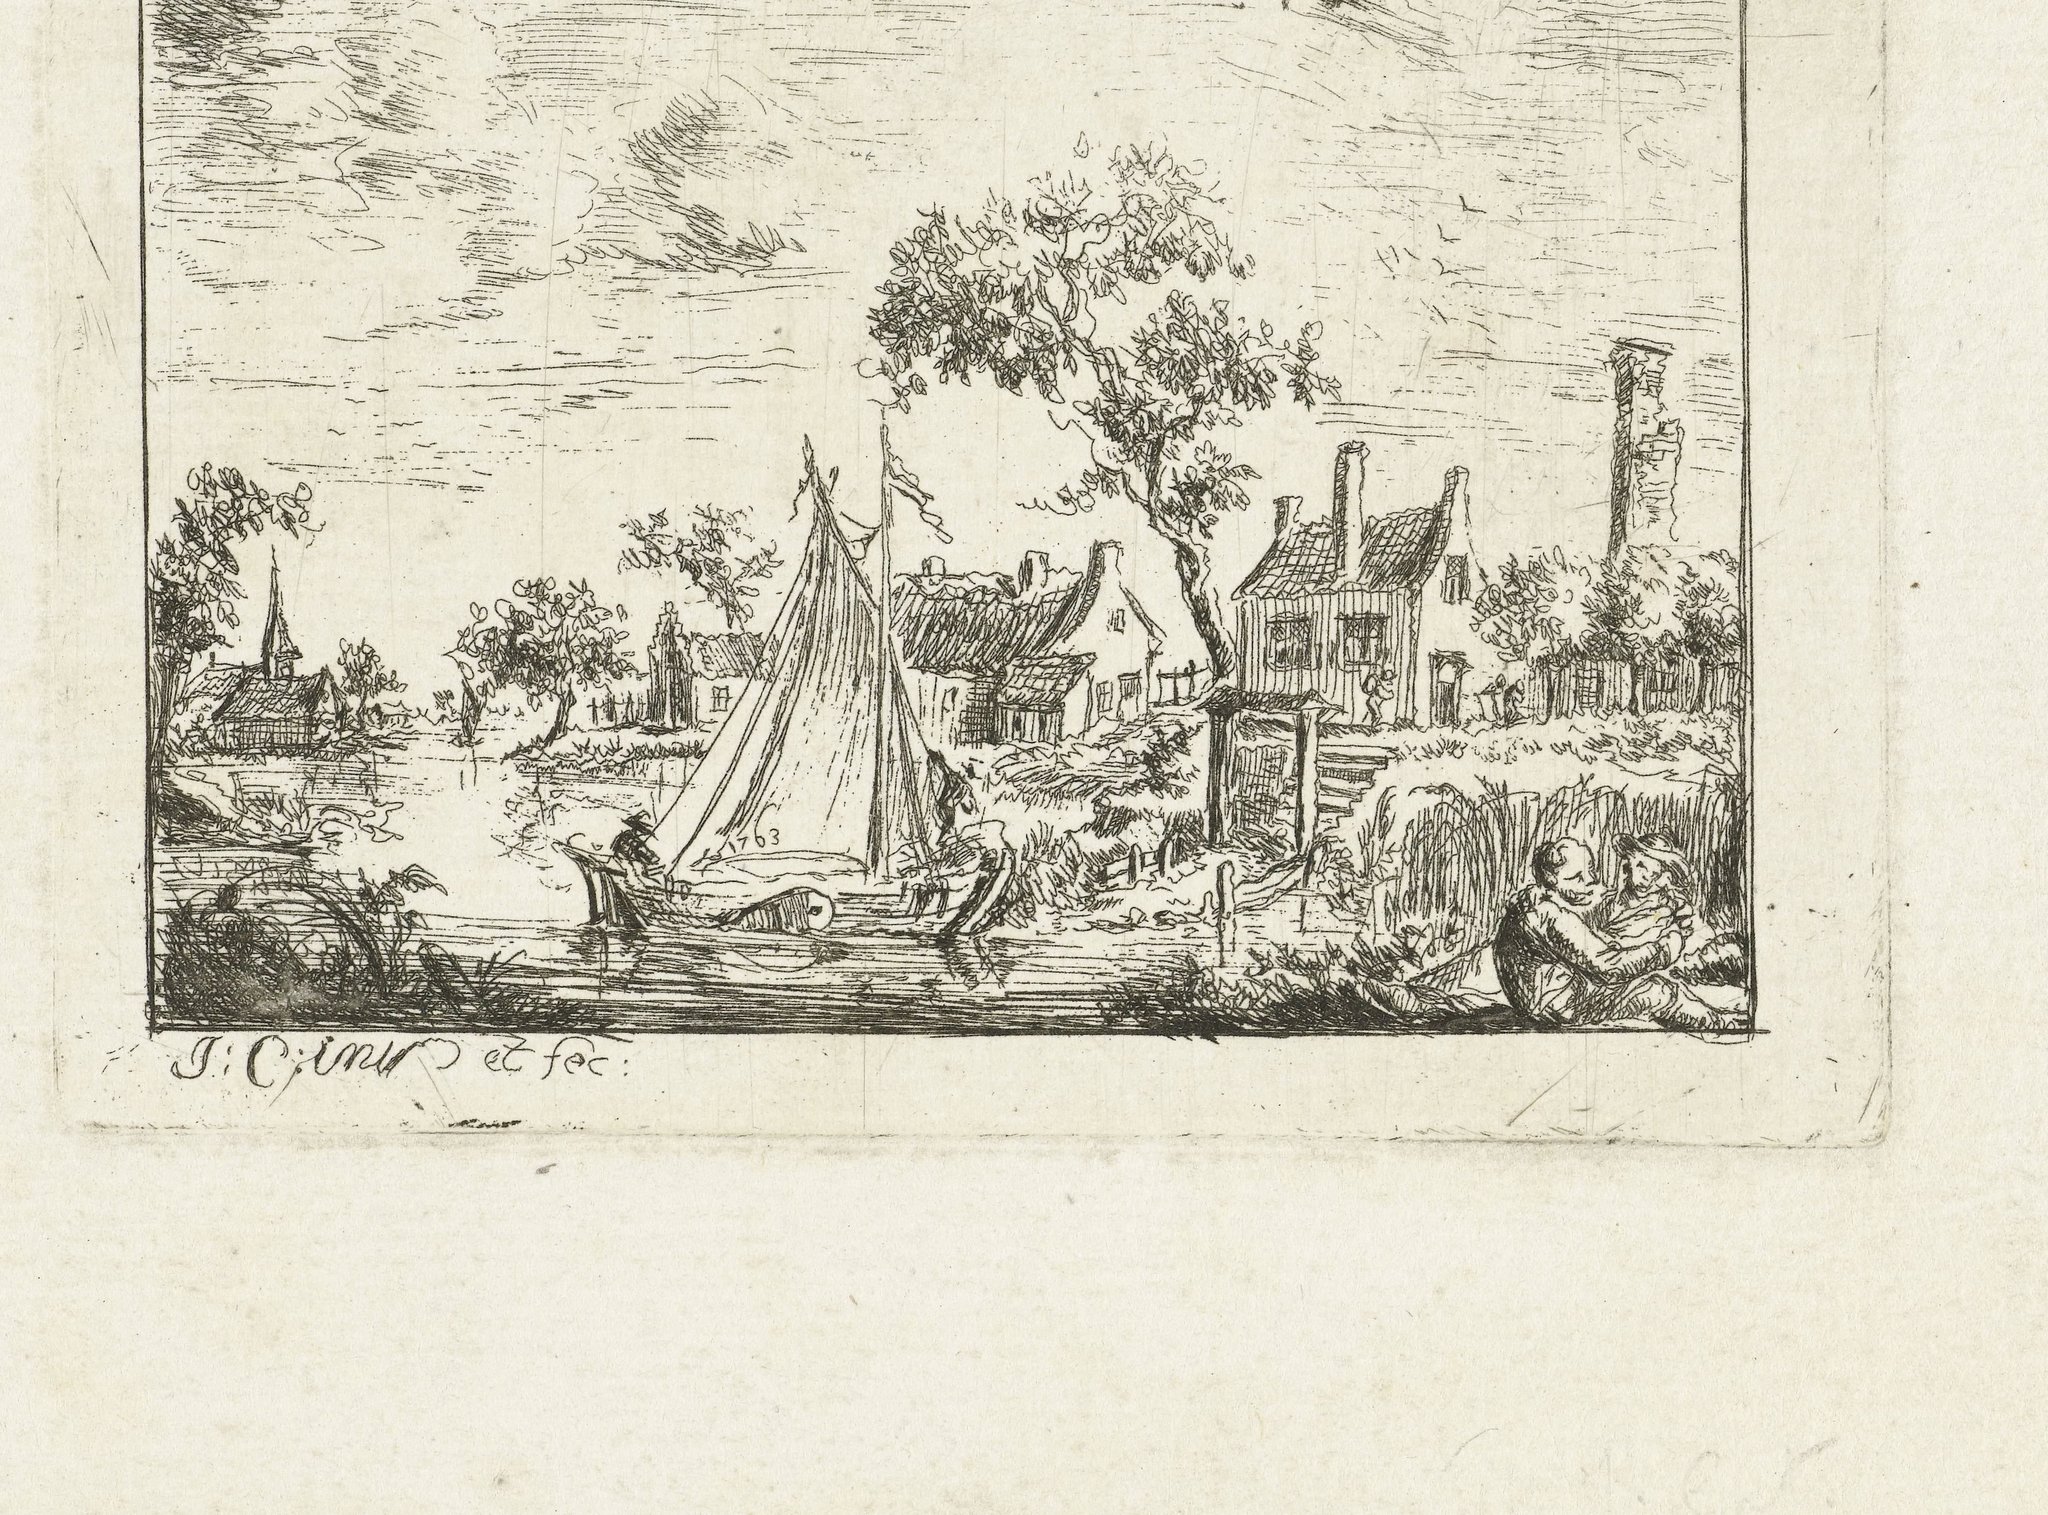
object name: print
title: Vaart met zeilboot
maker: jacob cats (1741-1799)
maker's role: draughtsman, print maker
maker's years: 1741-1799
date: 1763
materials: paper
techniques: etching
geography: amsterdam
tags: sailing-ship, sailing-boat, netherlands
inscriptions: collector's mark: Lugt 2228